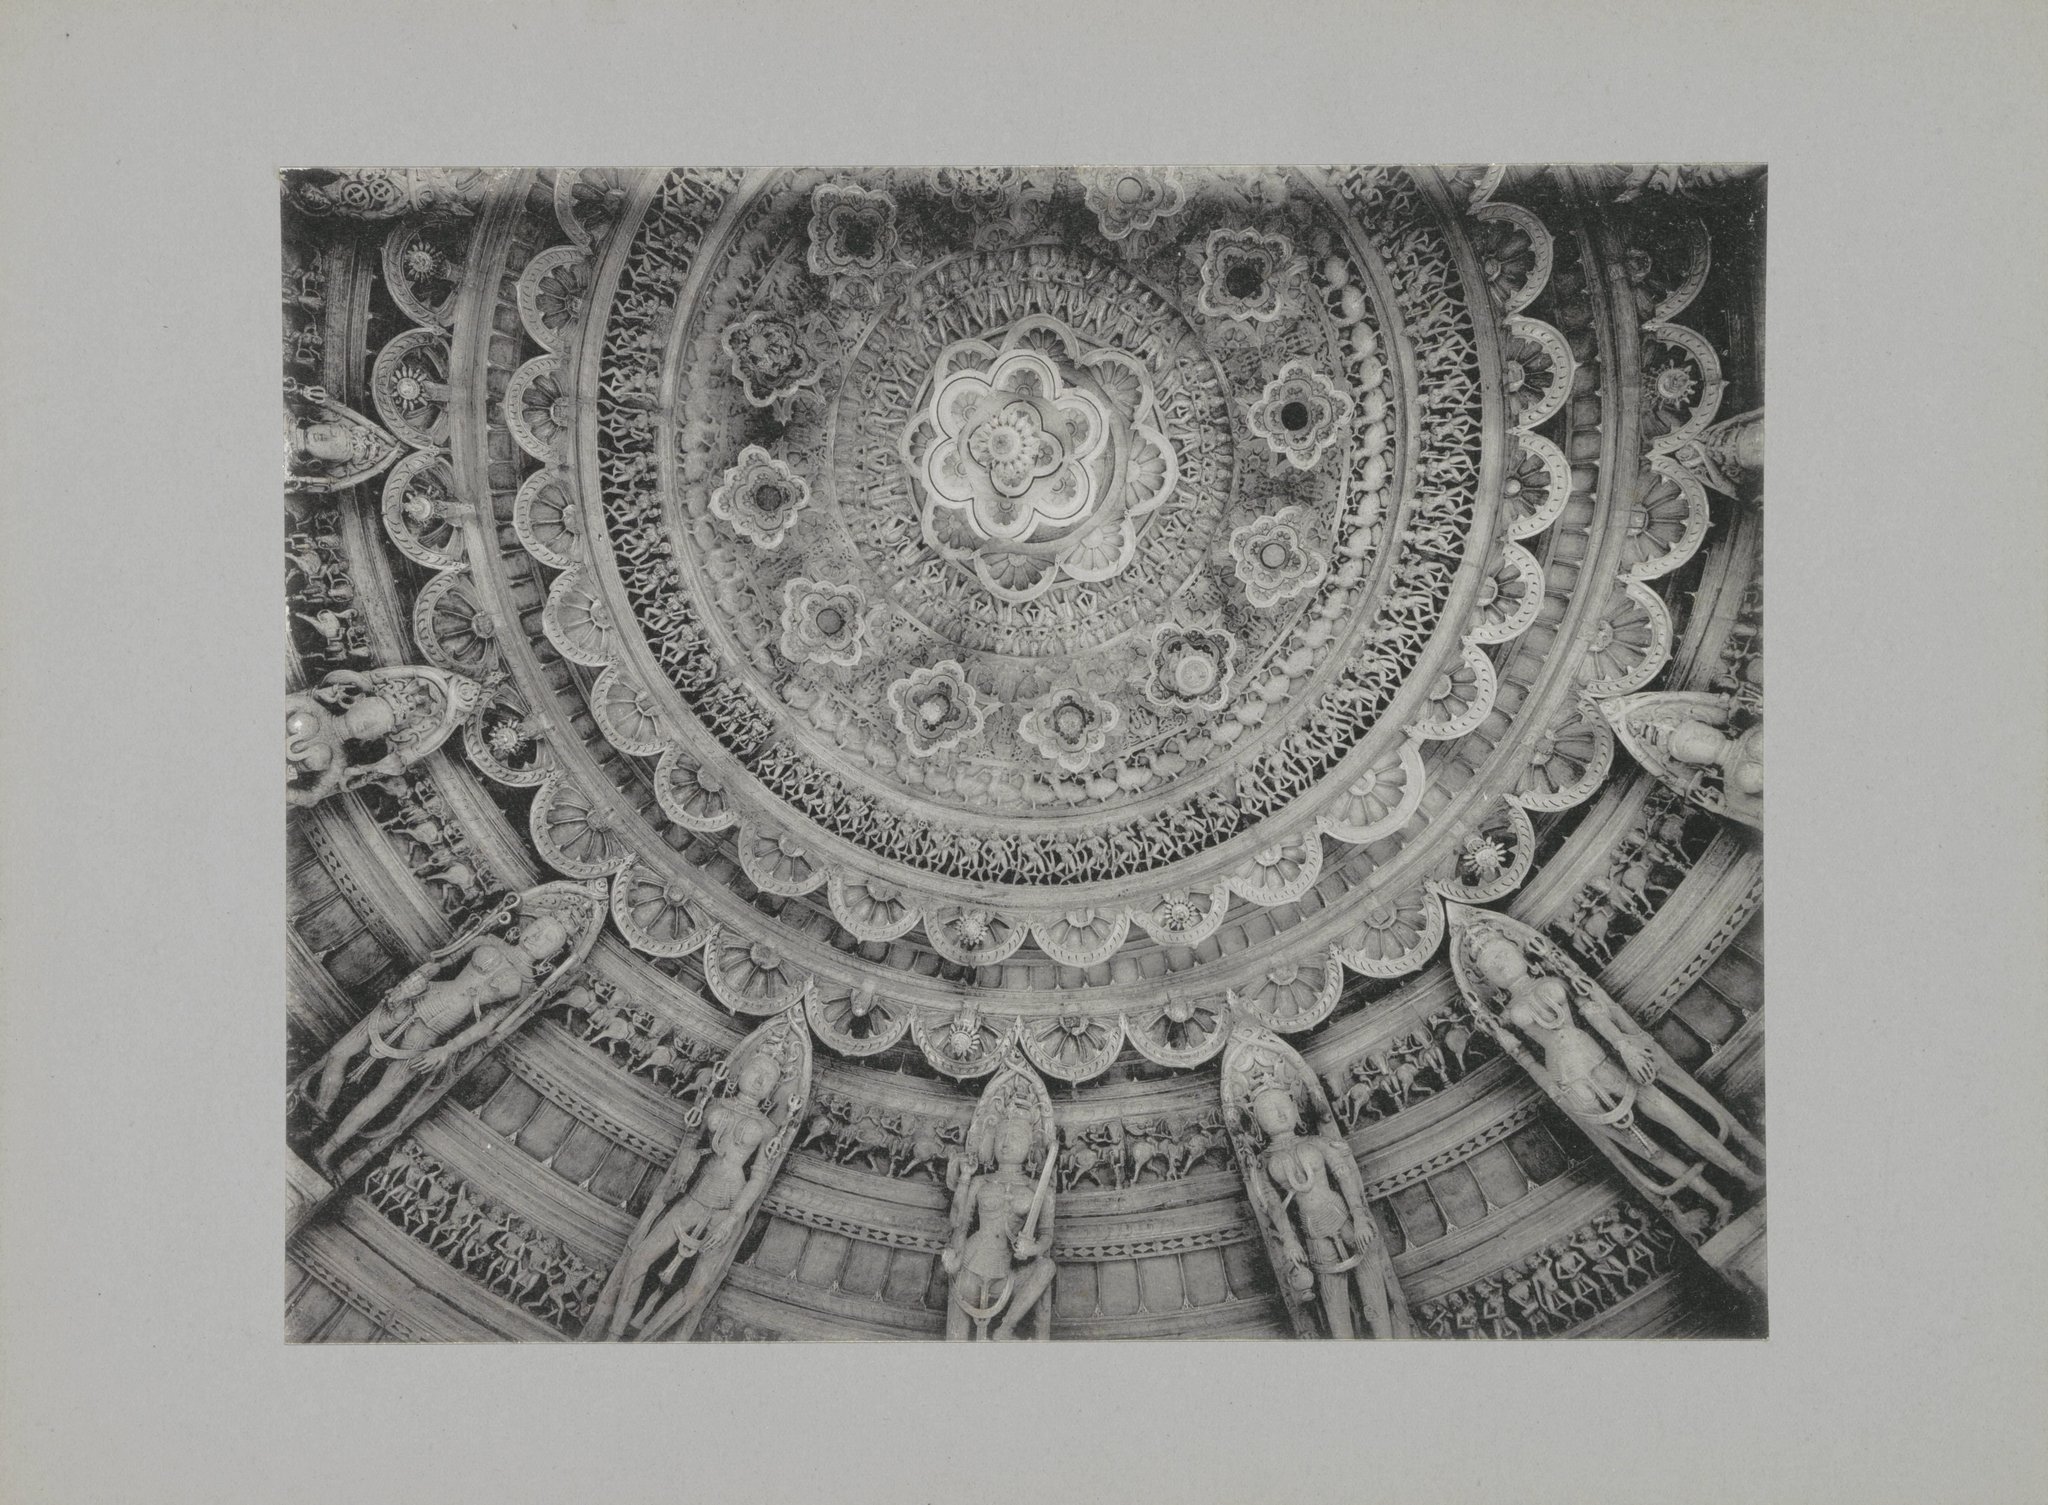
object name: photomechanical print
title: Ceiling of the Dilwara Temple at Mount Abu, Rajasthan, India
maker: Anonymous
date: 1895-1915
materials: cardboard, paper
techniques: photograph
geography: mount abu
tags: rajasthan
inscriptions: annotation: ‘69. Plafond i/d tempel te Dilwarra.’